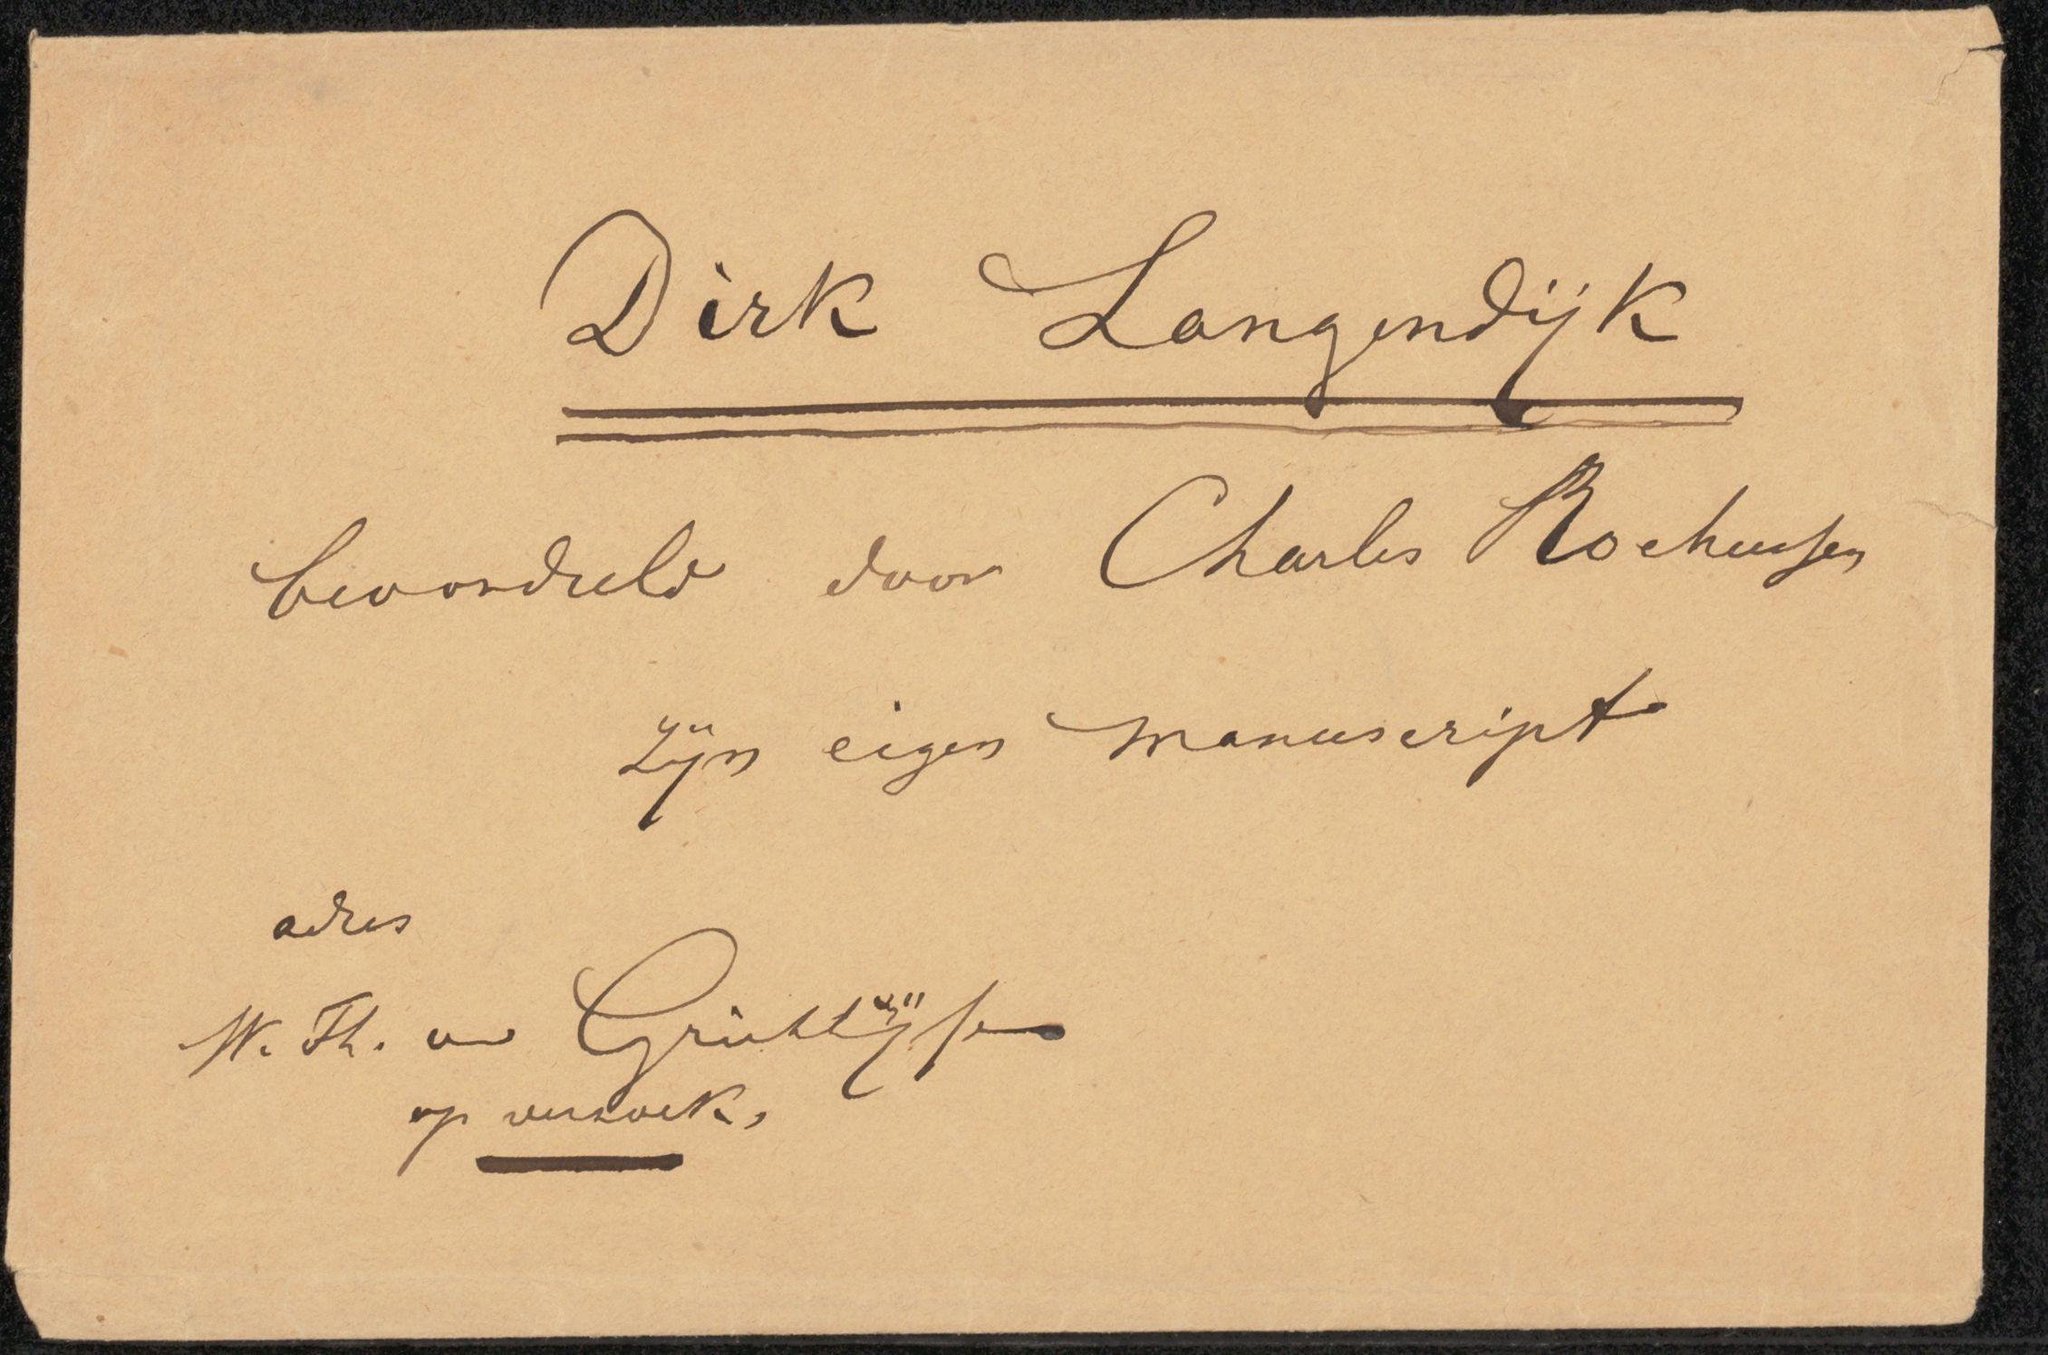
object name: envelope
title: Envelop aan Willem Theodorus van Griethuysen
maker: Anonymous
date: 1850-1919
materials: ink, paper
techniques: pen, writing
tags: rotterdam, painter, print maker, draughtsman, dirk langendijk, charles rochussen